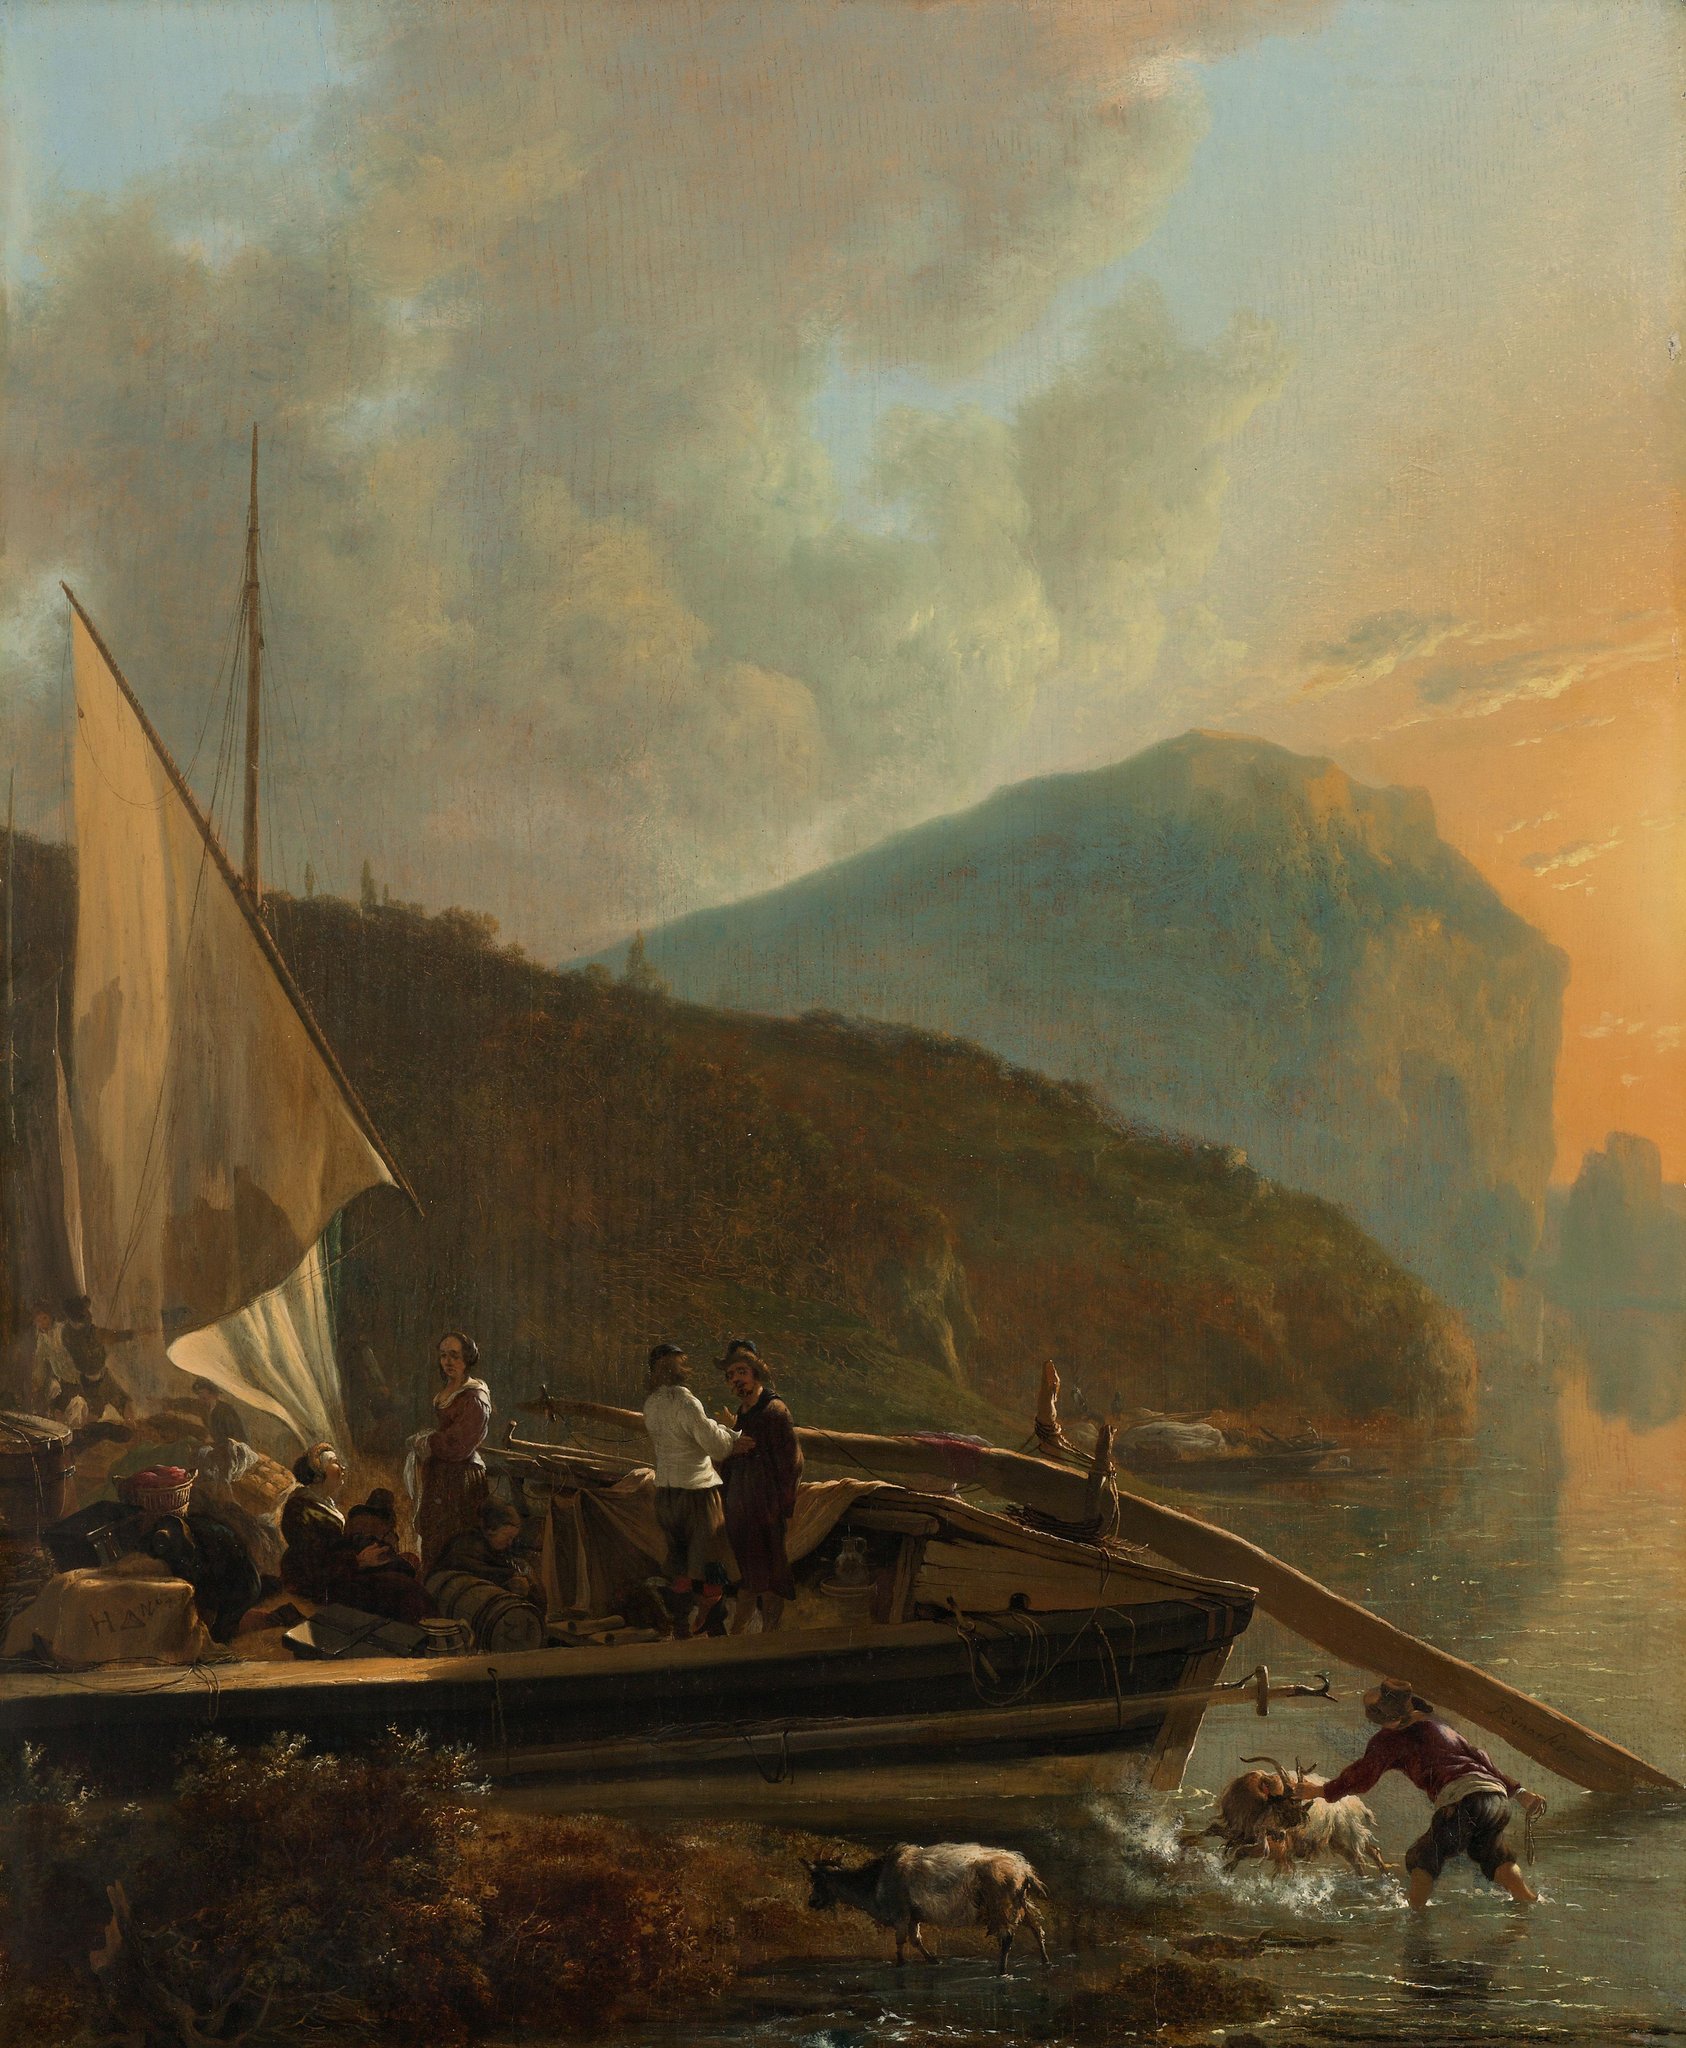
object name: painting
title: A Boat on the Bank of a River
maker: adam pijnacker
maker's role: draughtsman, painter, print maker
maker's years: 1620-1673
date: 1650-1655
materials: oil, panel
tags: river, passengers ~ ship, sailing-ship, sailing-boat (+ departure; weighing anchor)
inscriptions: signature: ‘APijnacker’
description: On returning to the Netherlands from his sojourn in Italy, Adam Pijnacker specialized in southern landscapes bathed in a golden Mediterranean light. His paintings are characterized by the tranquil atmosphere of a warm summer’s day. The long, raking shadows herald the fall of evening.